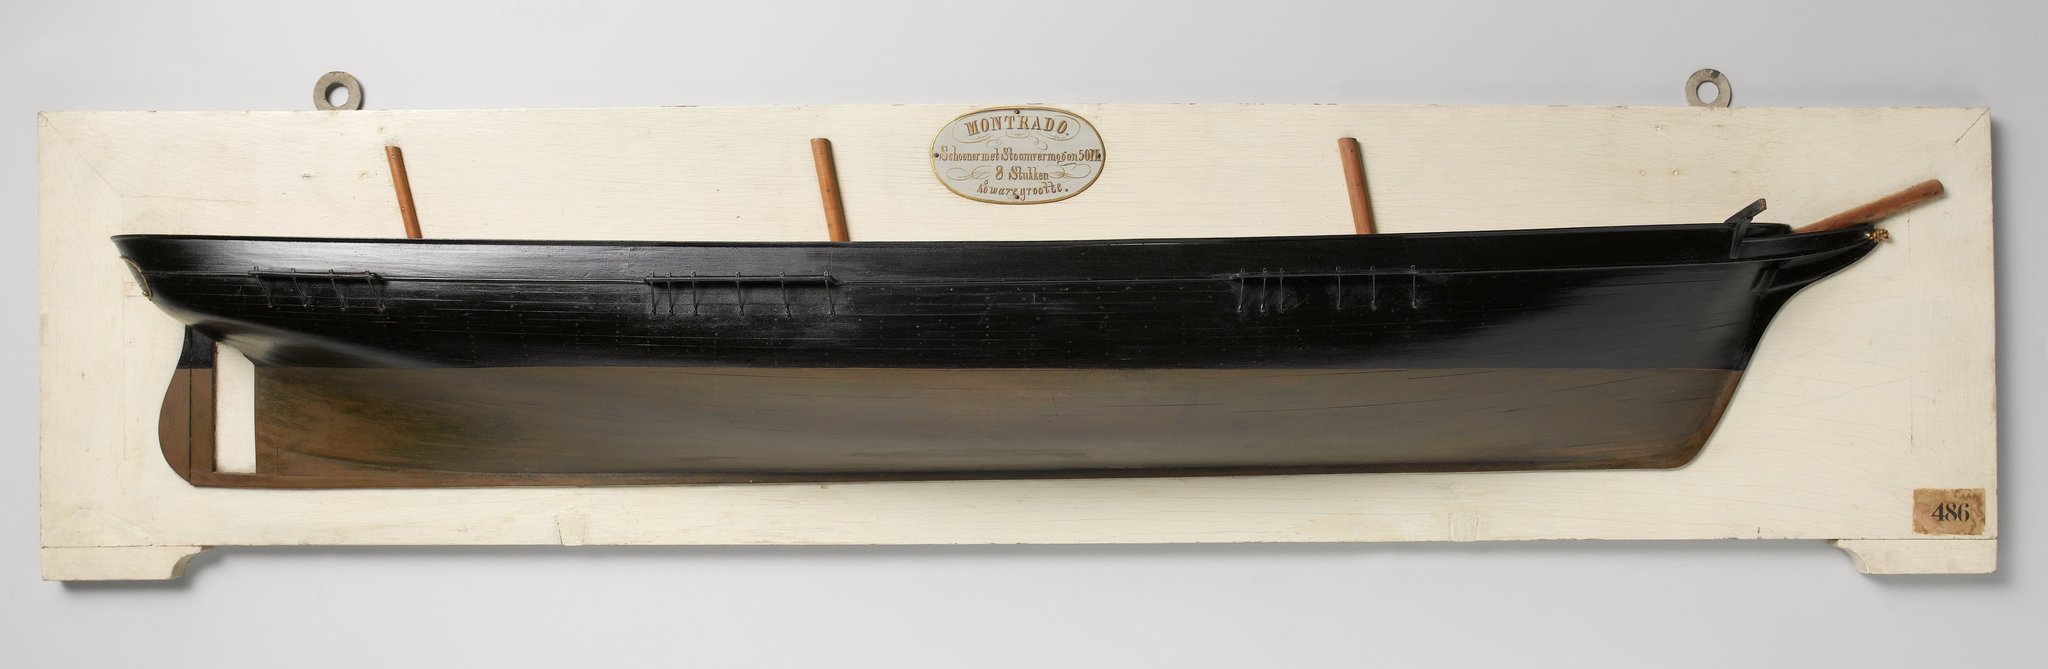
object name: ship model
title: Half Model of a Screw Steamer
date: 1855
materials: brass, wood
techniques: polychromy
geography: amsterdam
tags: vuurpijl (schip), montrado (schip)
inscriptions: inscription, top centre, on an oval light blue label: ‘MONTRADO / Schooner met Stoomvermogen 50 PK / 8 Stukken / 1/40 ware grootte.’, label, bottom right: ‘486’ former inventory label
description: De schroefschoener van 8 stukken de Vuurpijl, lang 40 m., werd gebouwd in 1853-1854 in Amsterdam door A.E. Tromp; herdoopt Montrado in 1854, in verband met de onderwerping van de Chinese kongsis op West-Borneo. Zij deed dienst in Oost-Indië, waar zij werd verkocht in 1867. Het was het eerste schip van de Nederlandse Marine met een pijpketel.